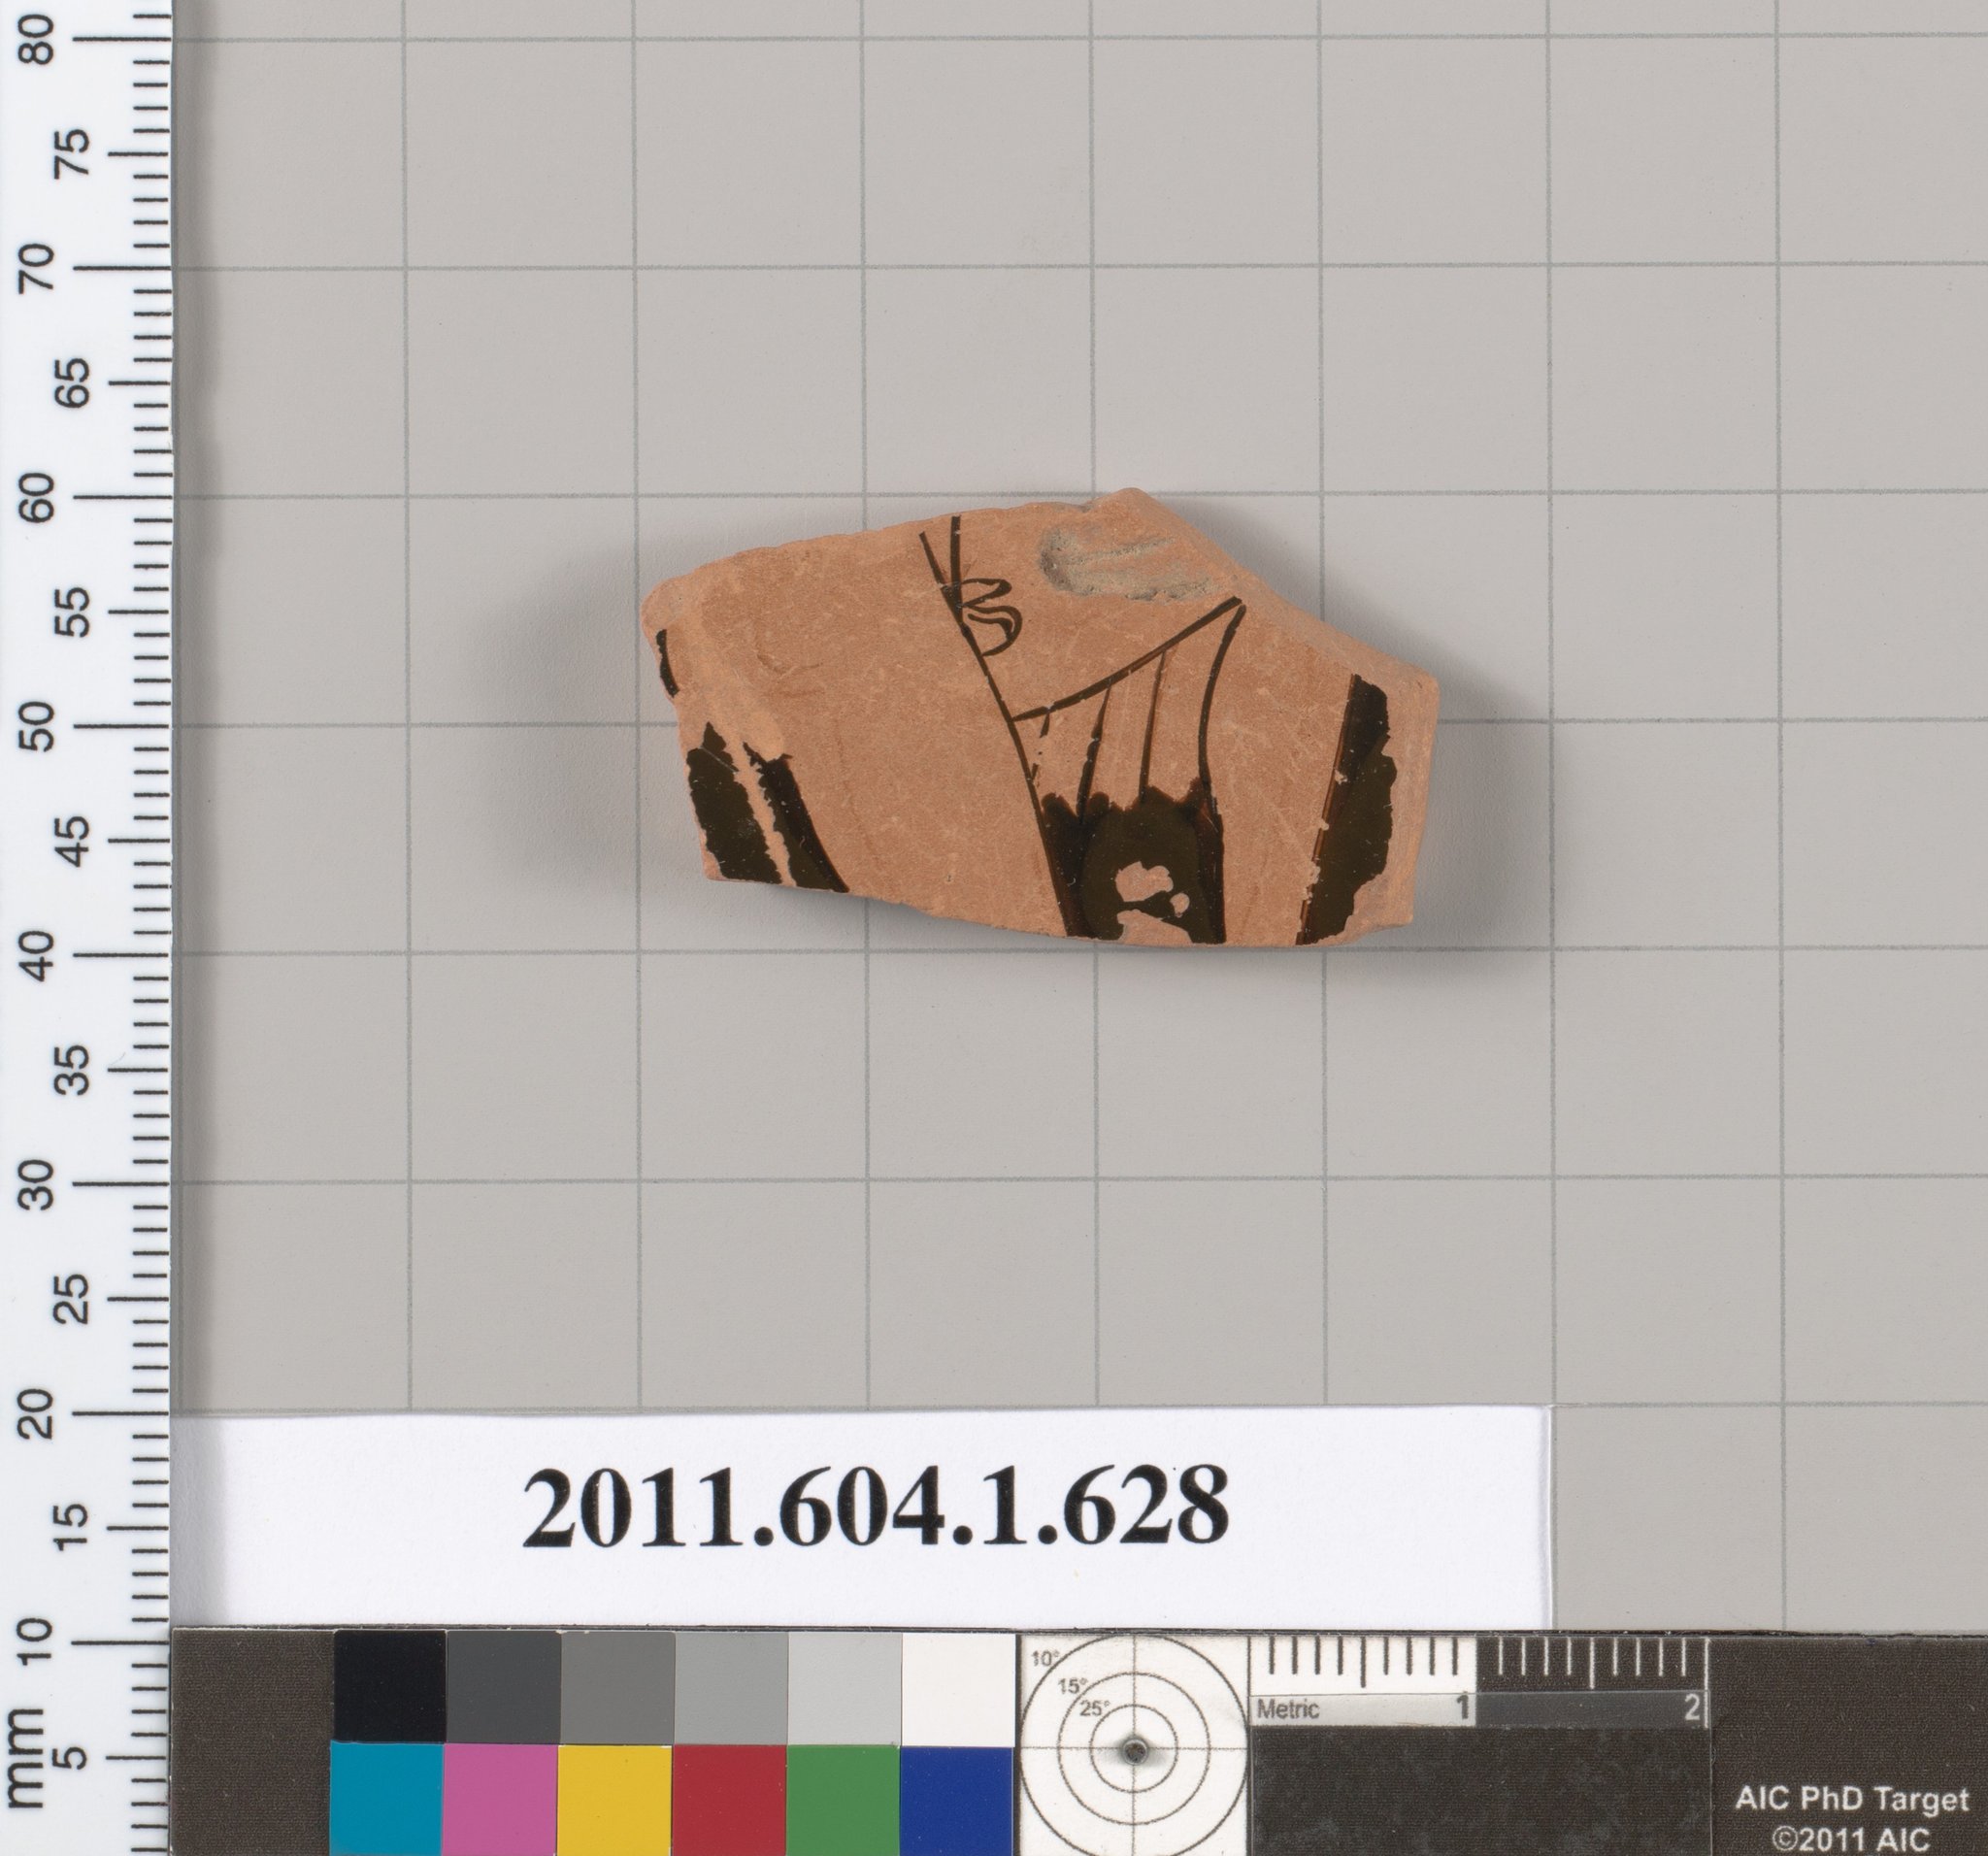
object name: kylix fragment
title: Terracotta fragment of a kylix (drinking cup)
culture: greek, attic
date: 475-451 BCE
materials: terracotta